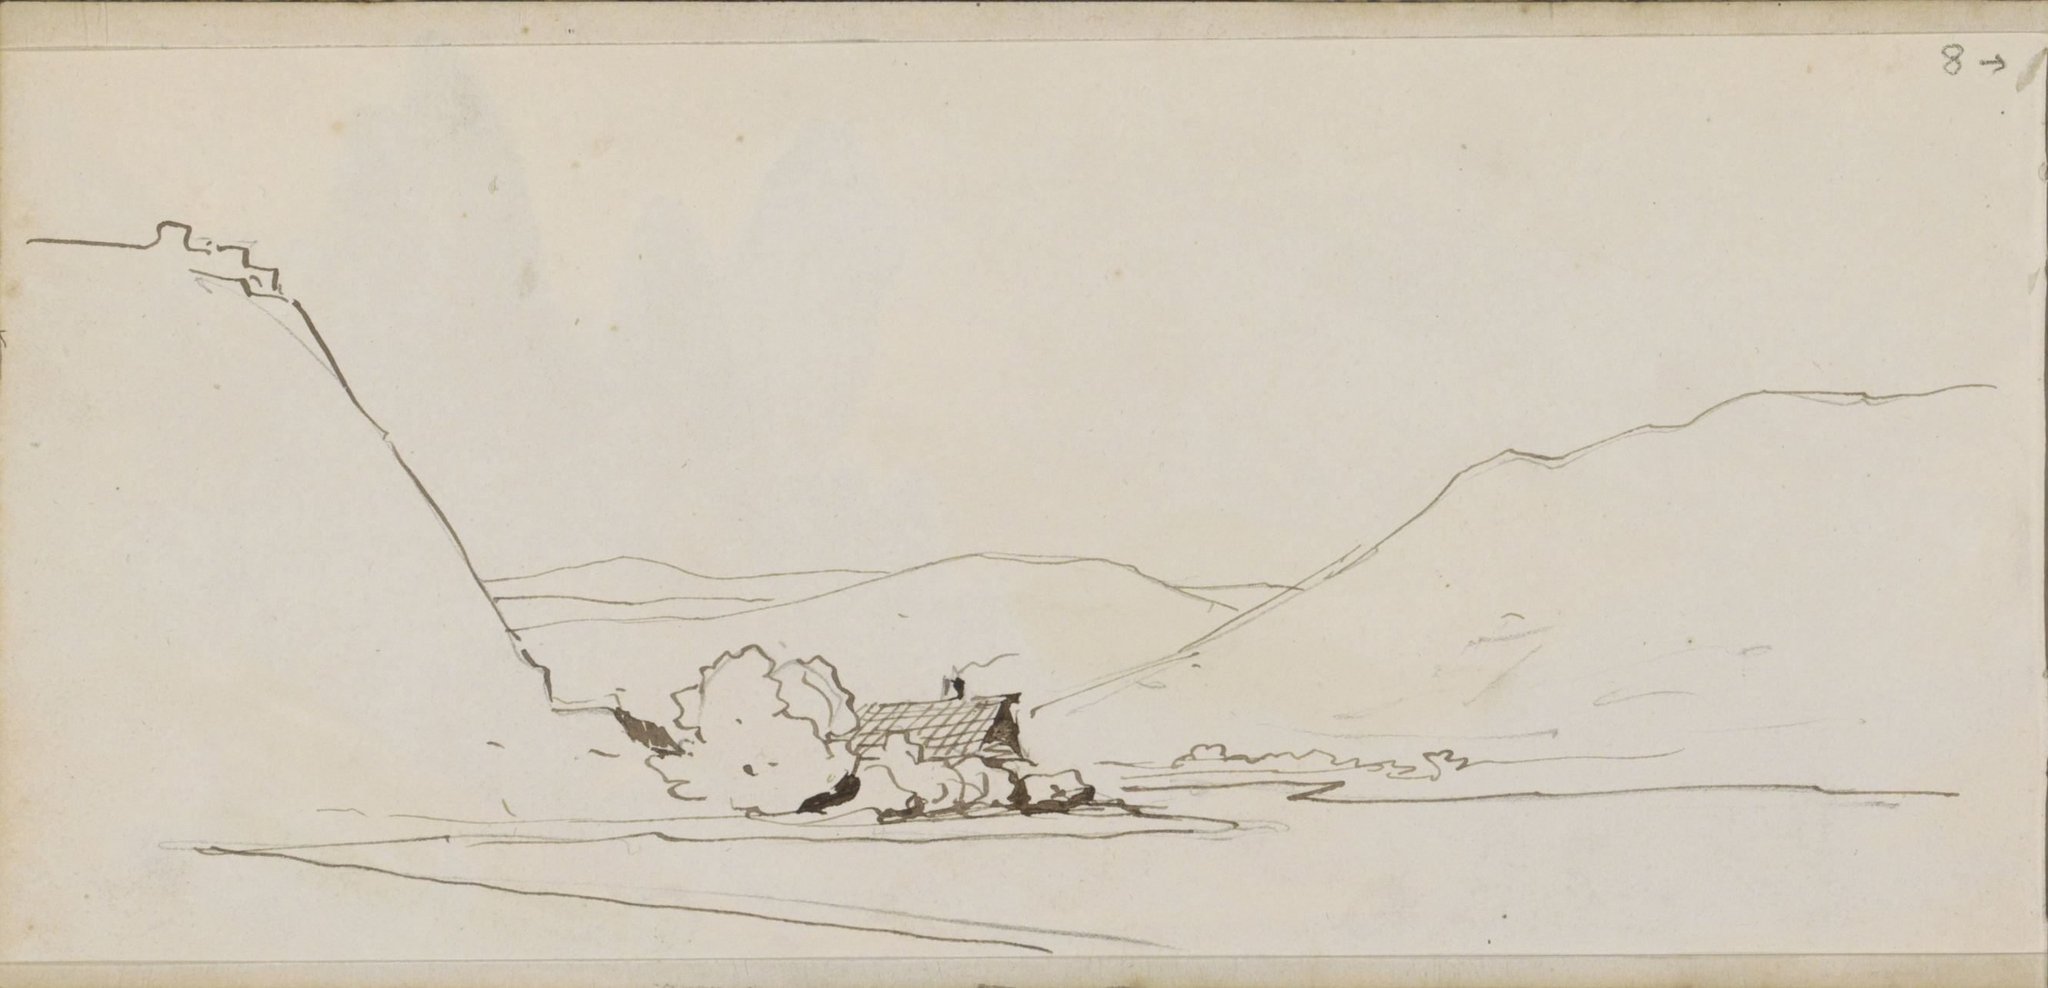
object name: sketchbook leaf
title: Huis tussen de bergen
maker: johannes tavenraat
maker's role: draughtsman, painter, print maker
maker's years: 1809-1881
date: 1840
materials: ink, paper, pencil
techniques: pen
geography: schwarzburg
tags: rural housing, e.g. country-house, villa, cottage, mountains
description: Blad 7 verso uit een schetsboek met 63 bladen.